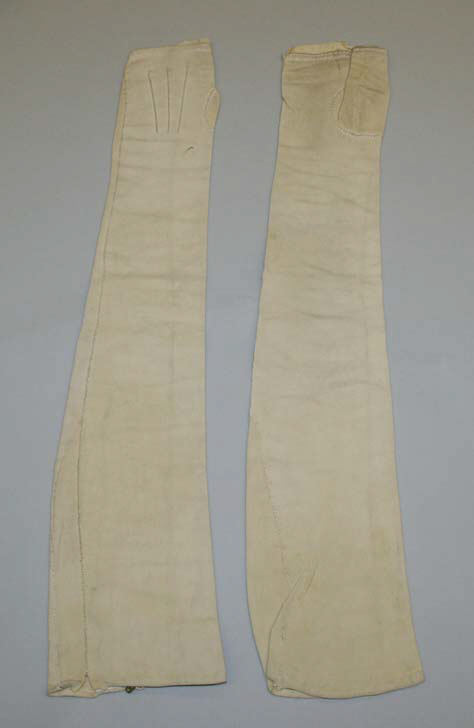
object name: mitt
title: Mitts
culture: american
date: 1801-1833